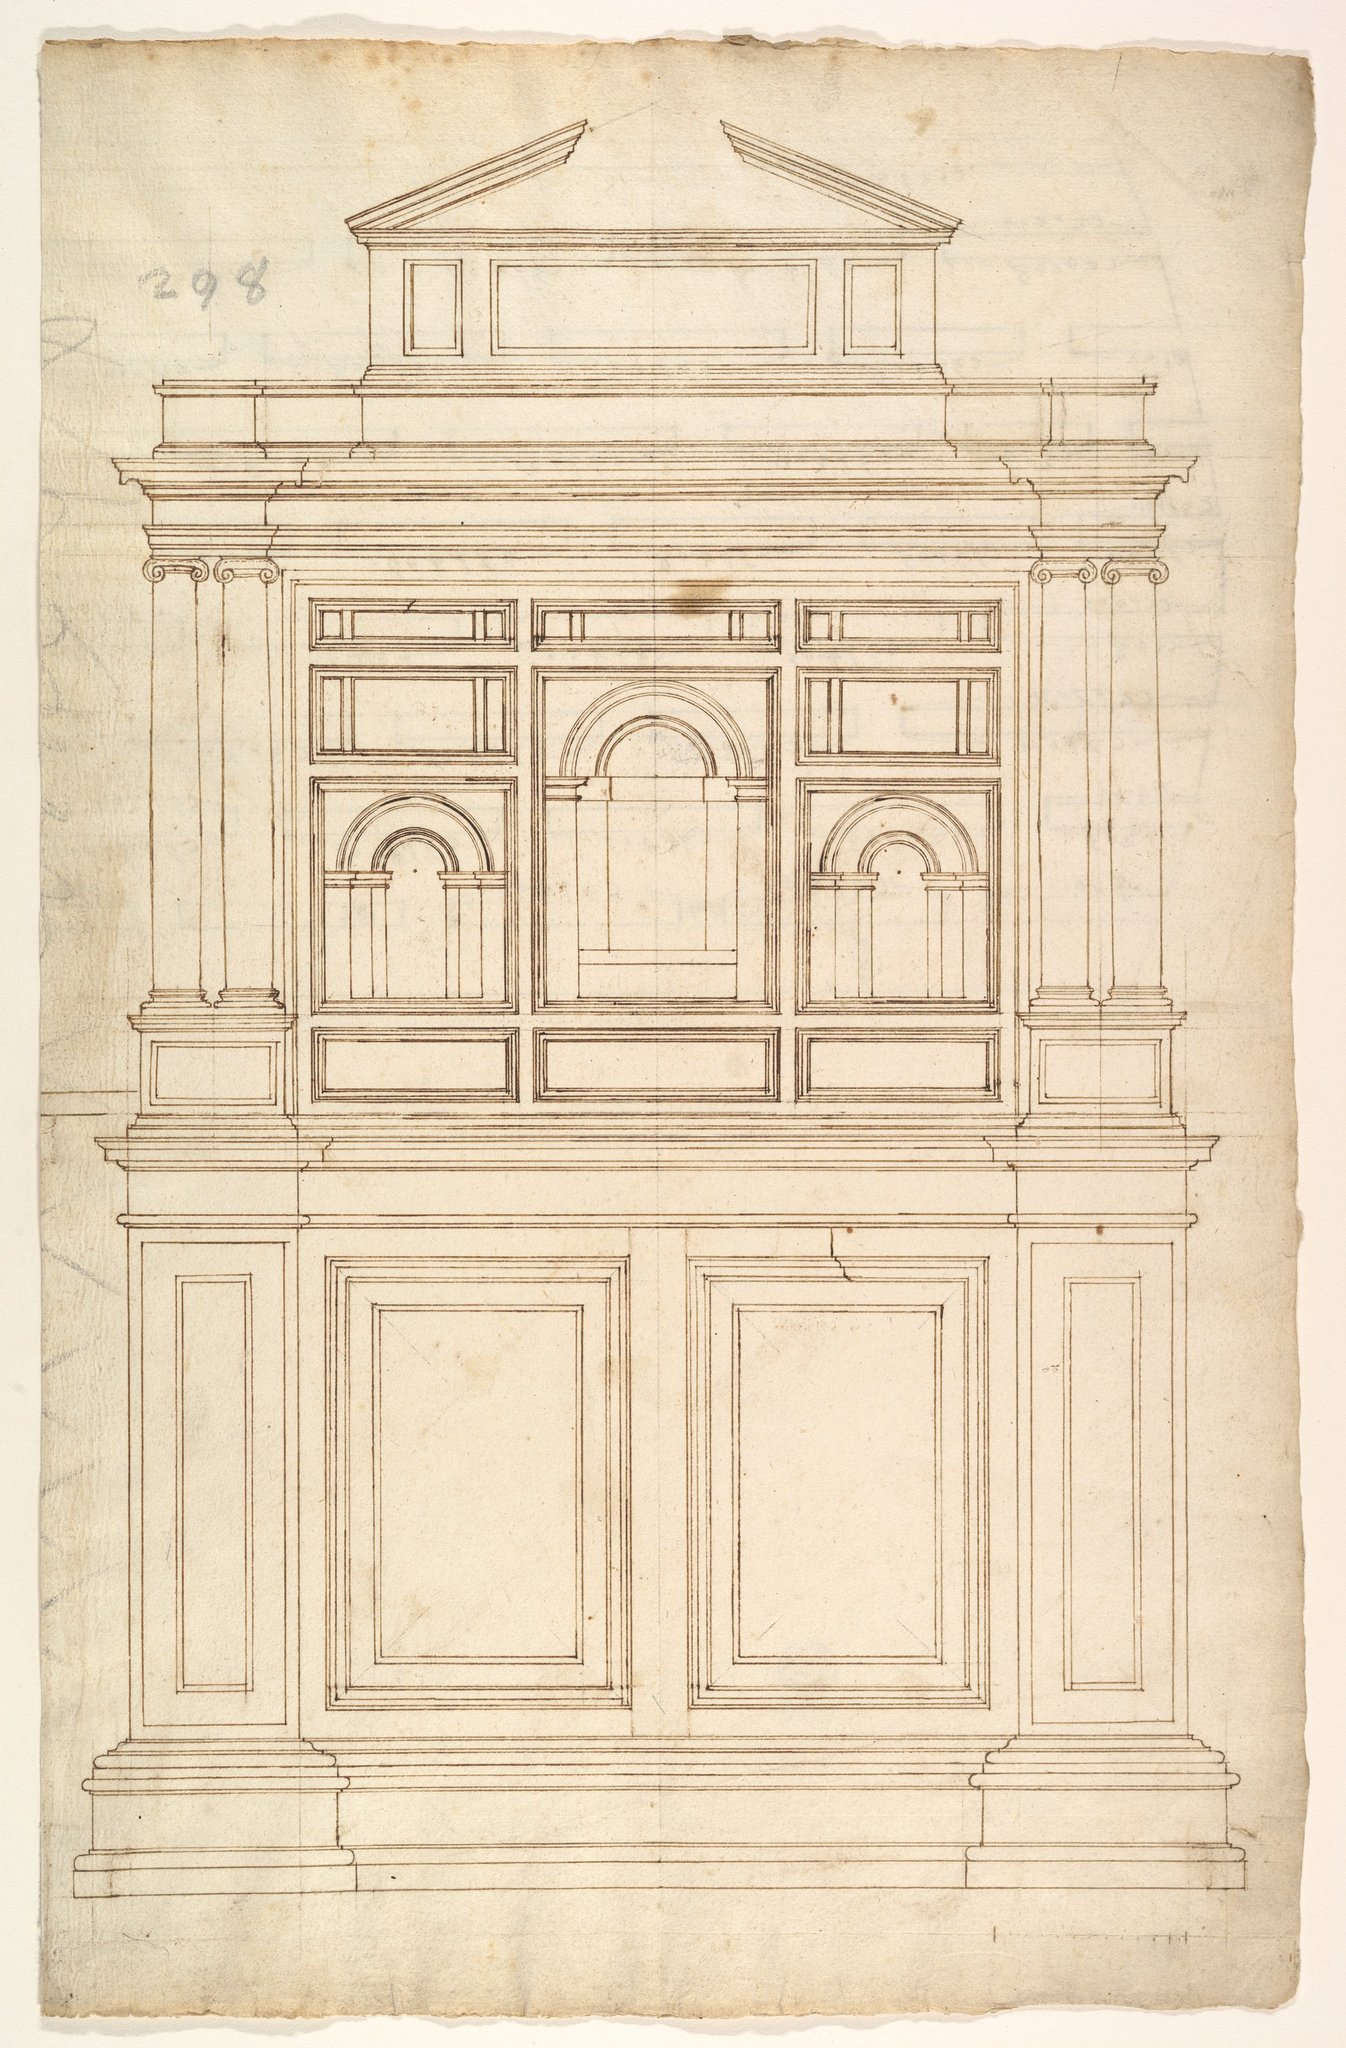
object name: drawing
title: Court Cupboard (recto); Half-page of rectangles, numbered and lettered (verso)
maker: anonymous, french, 16th century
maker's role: artist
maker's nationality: french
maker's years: 1500-1600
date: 1501-1600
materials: ink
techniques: pen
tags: architecture